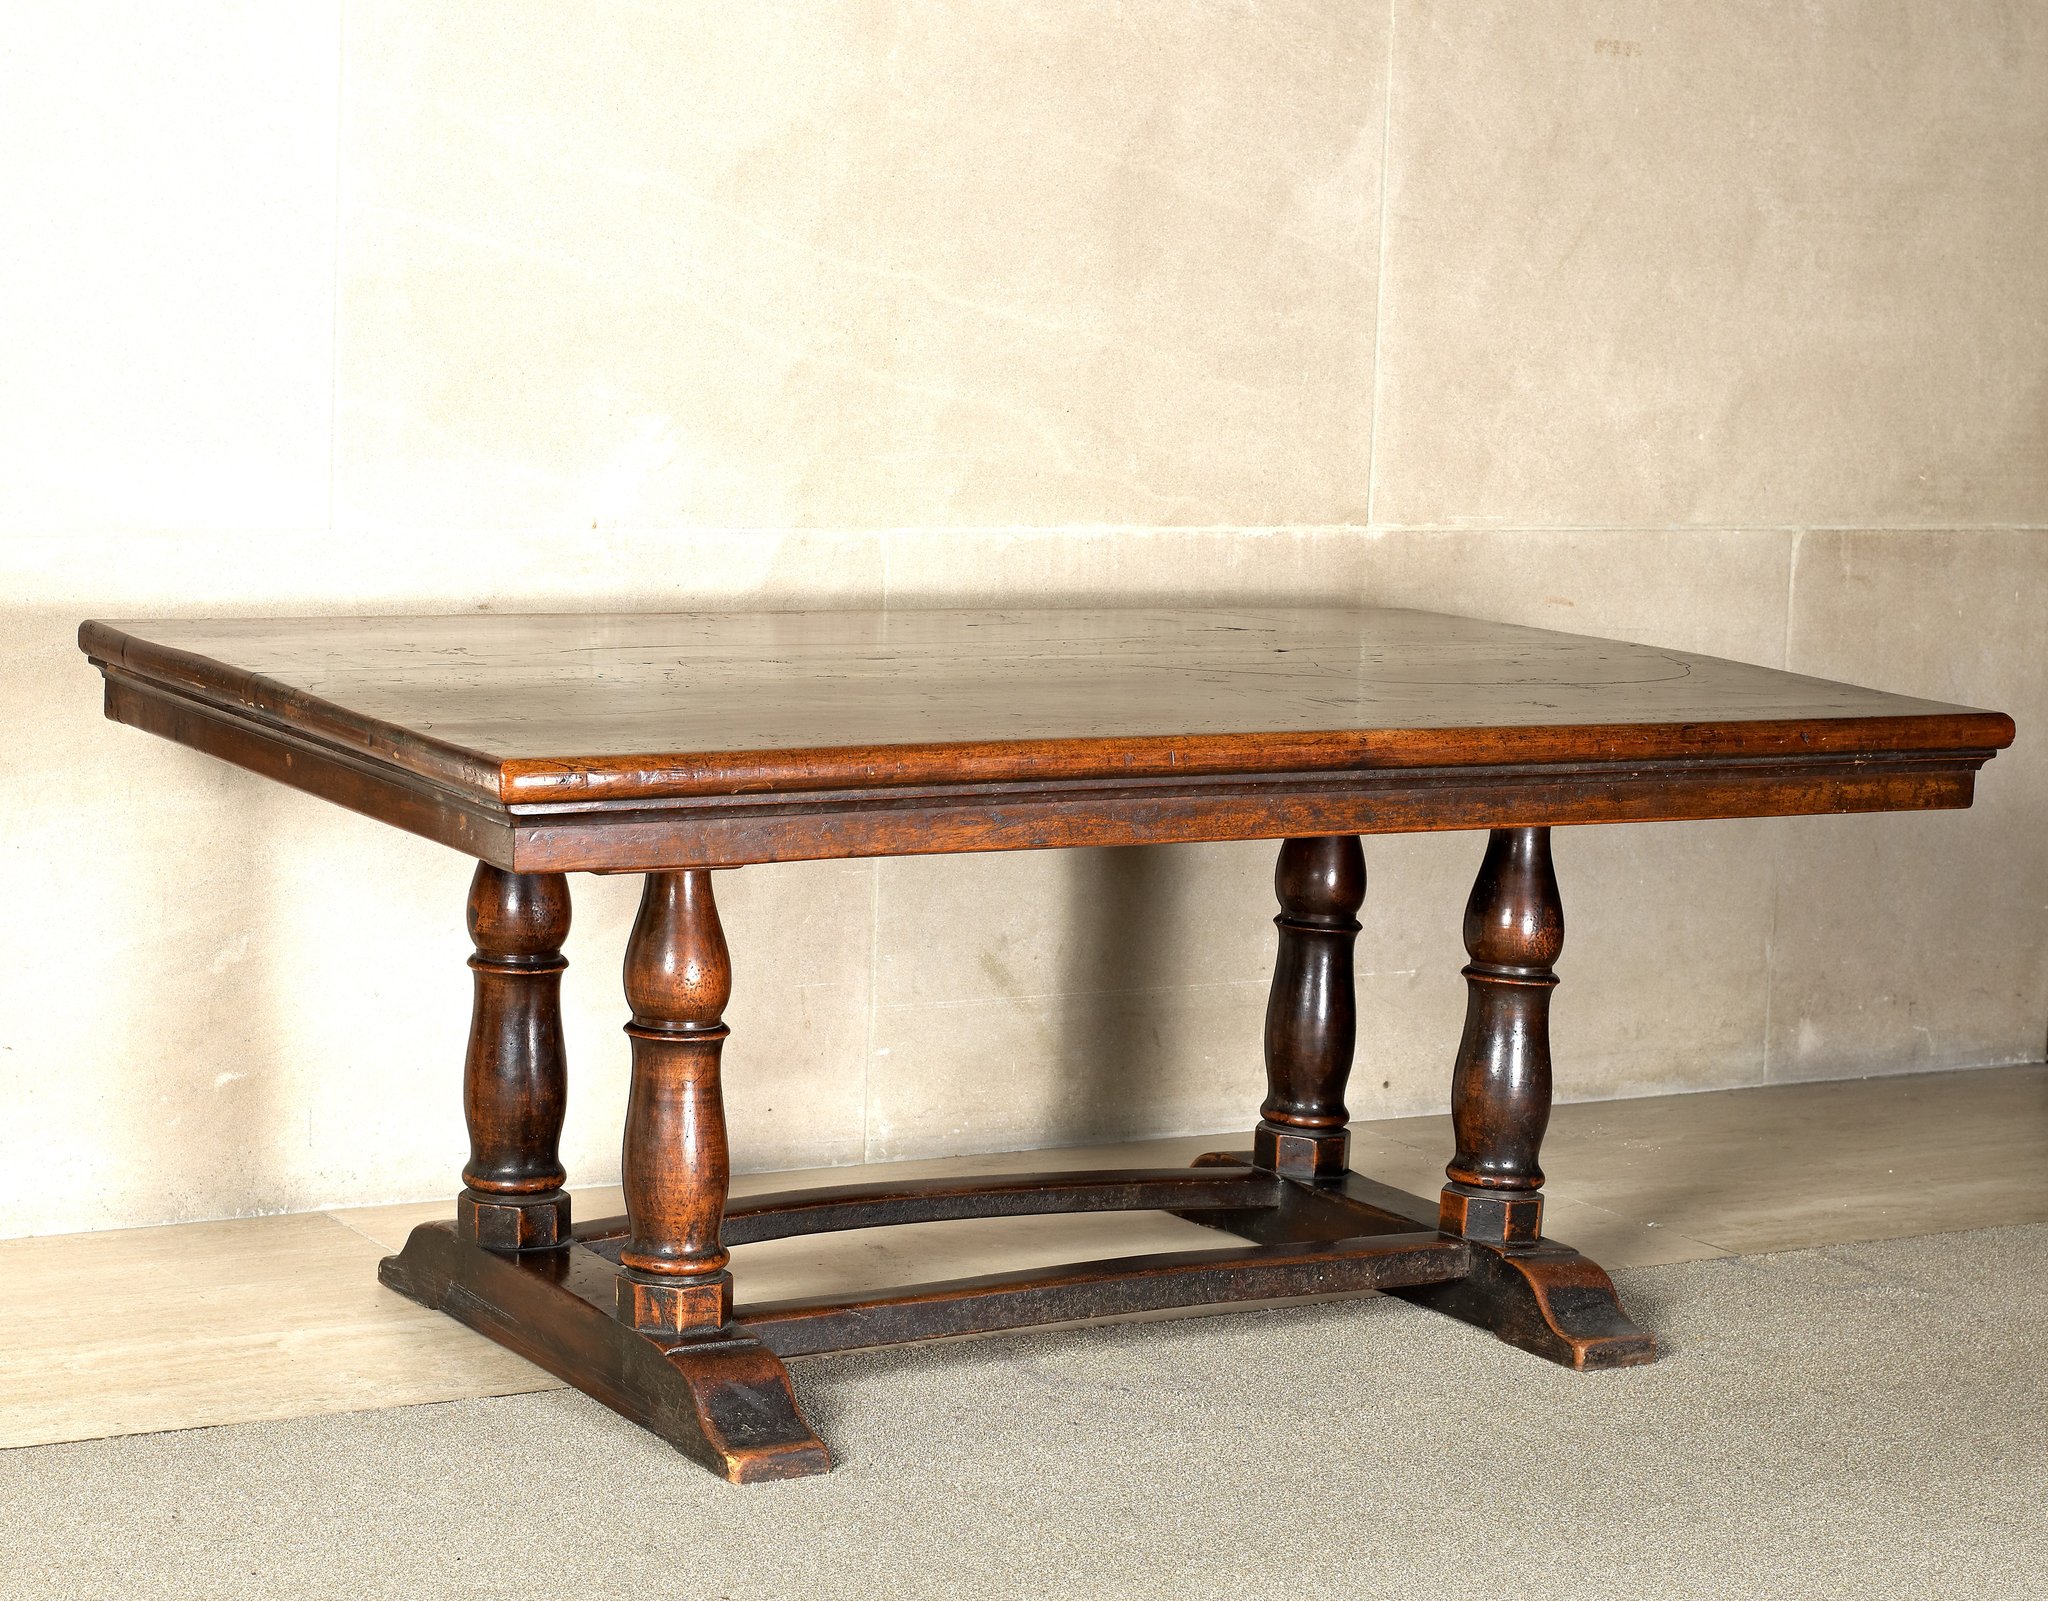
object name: table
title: Oblong Table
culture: italian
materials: wood